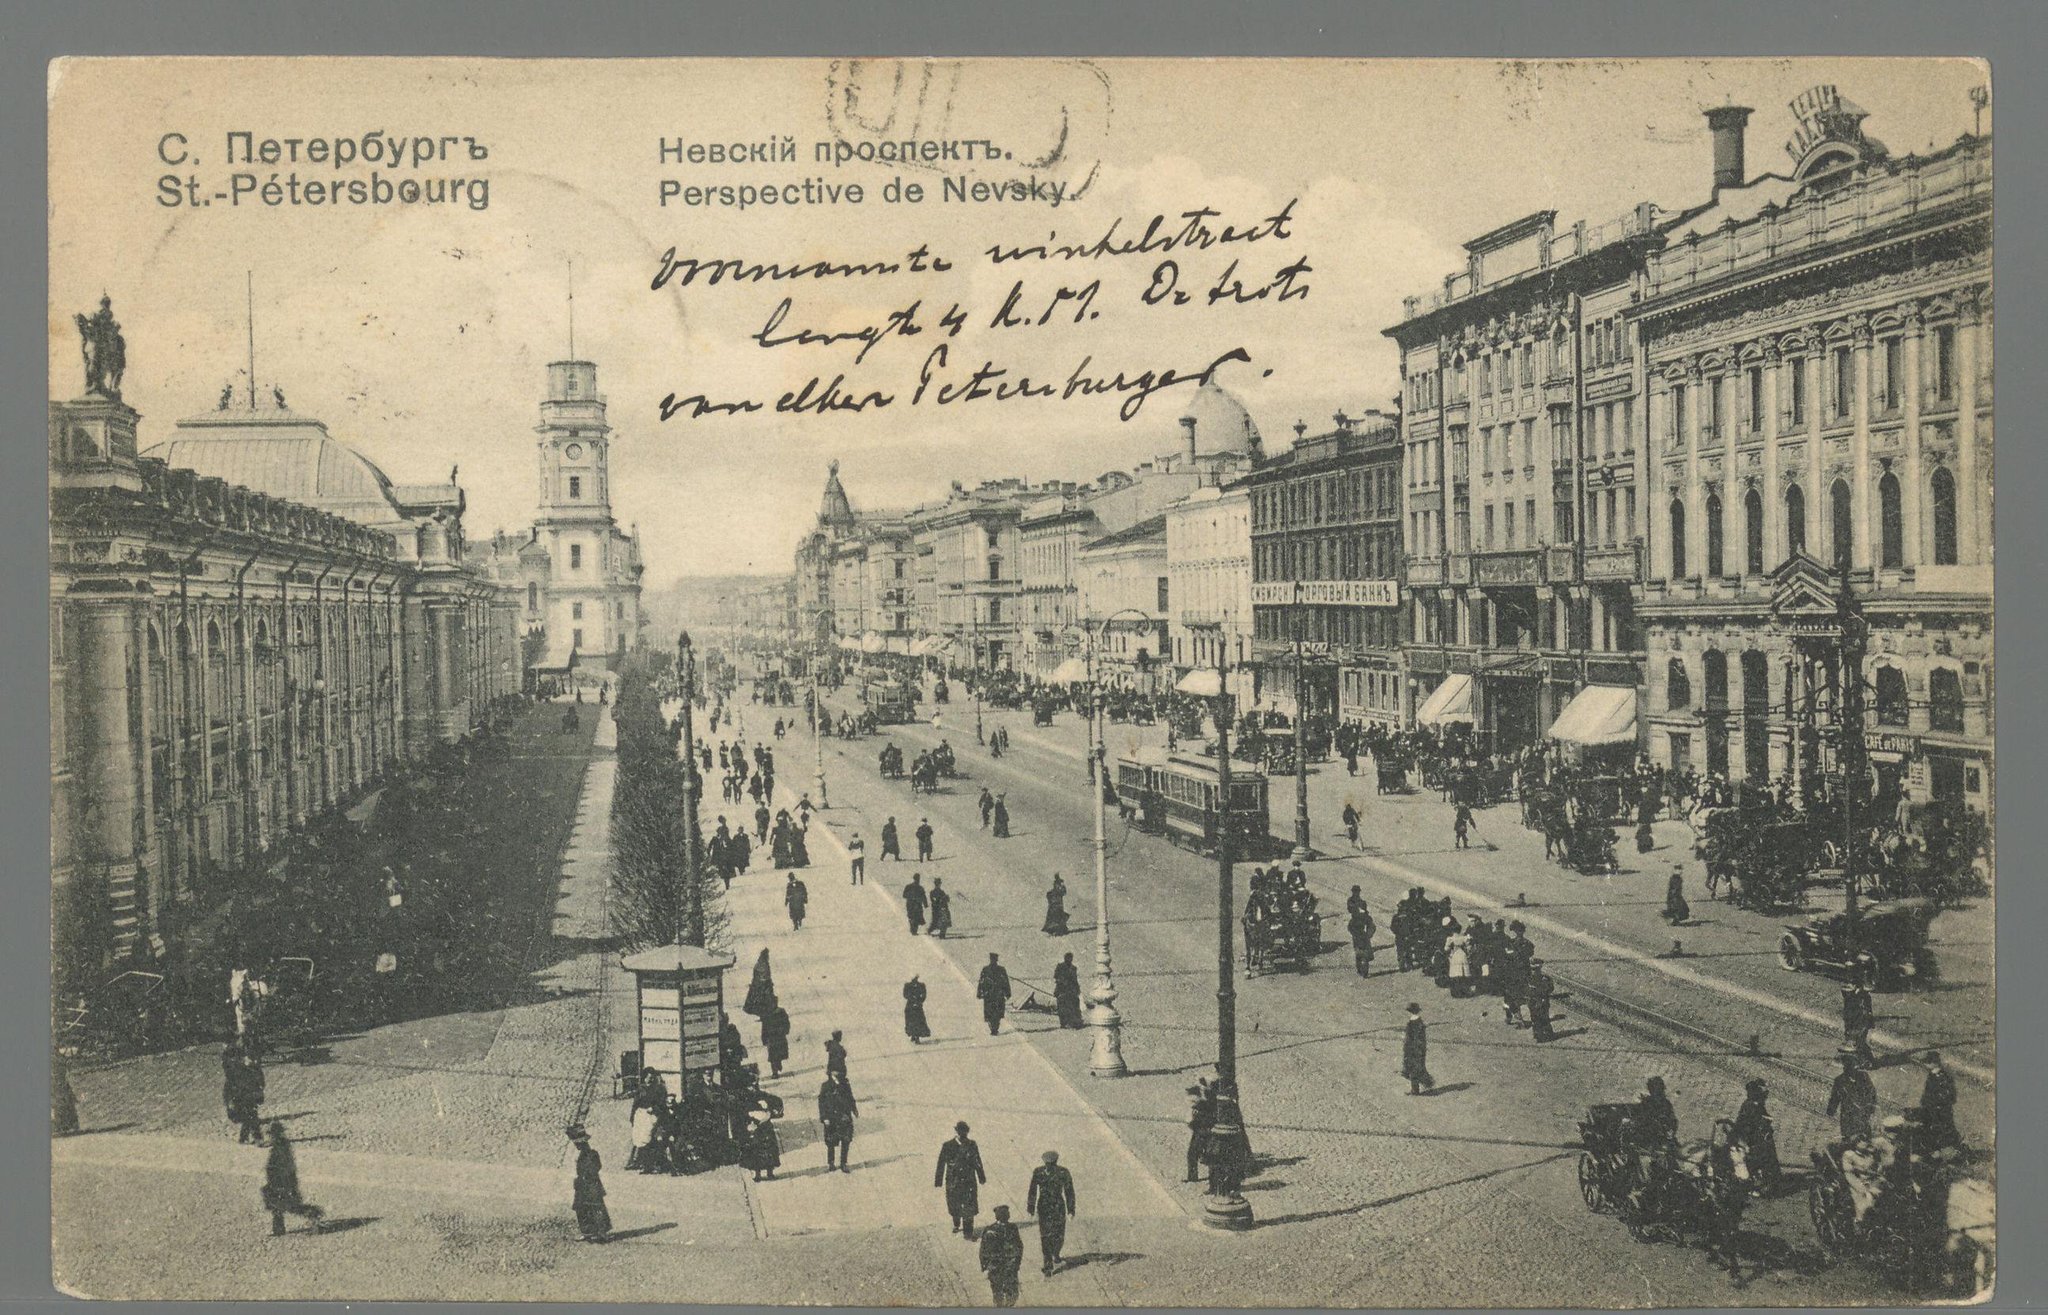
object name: photomechanical print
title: St.-Pétersbourg. Perspective de Nevsky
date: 1904-1909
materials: cardboard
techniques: photograph, writing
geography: sint-petersburg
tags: square, place, circus, etc., tram, poster-pillar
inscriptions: poststempel, verso, gestempeld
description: Boven de Franse titel staat de titel in het Russisch.